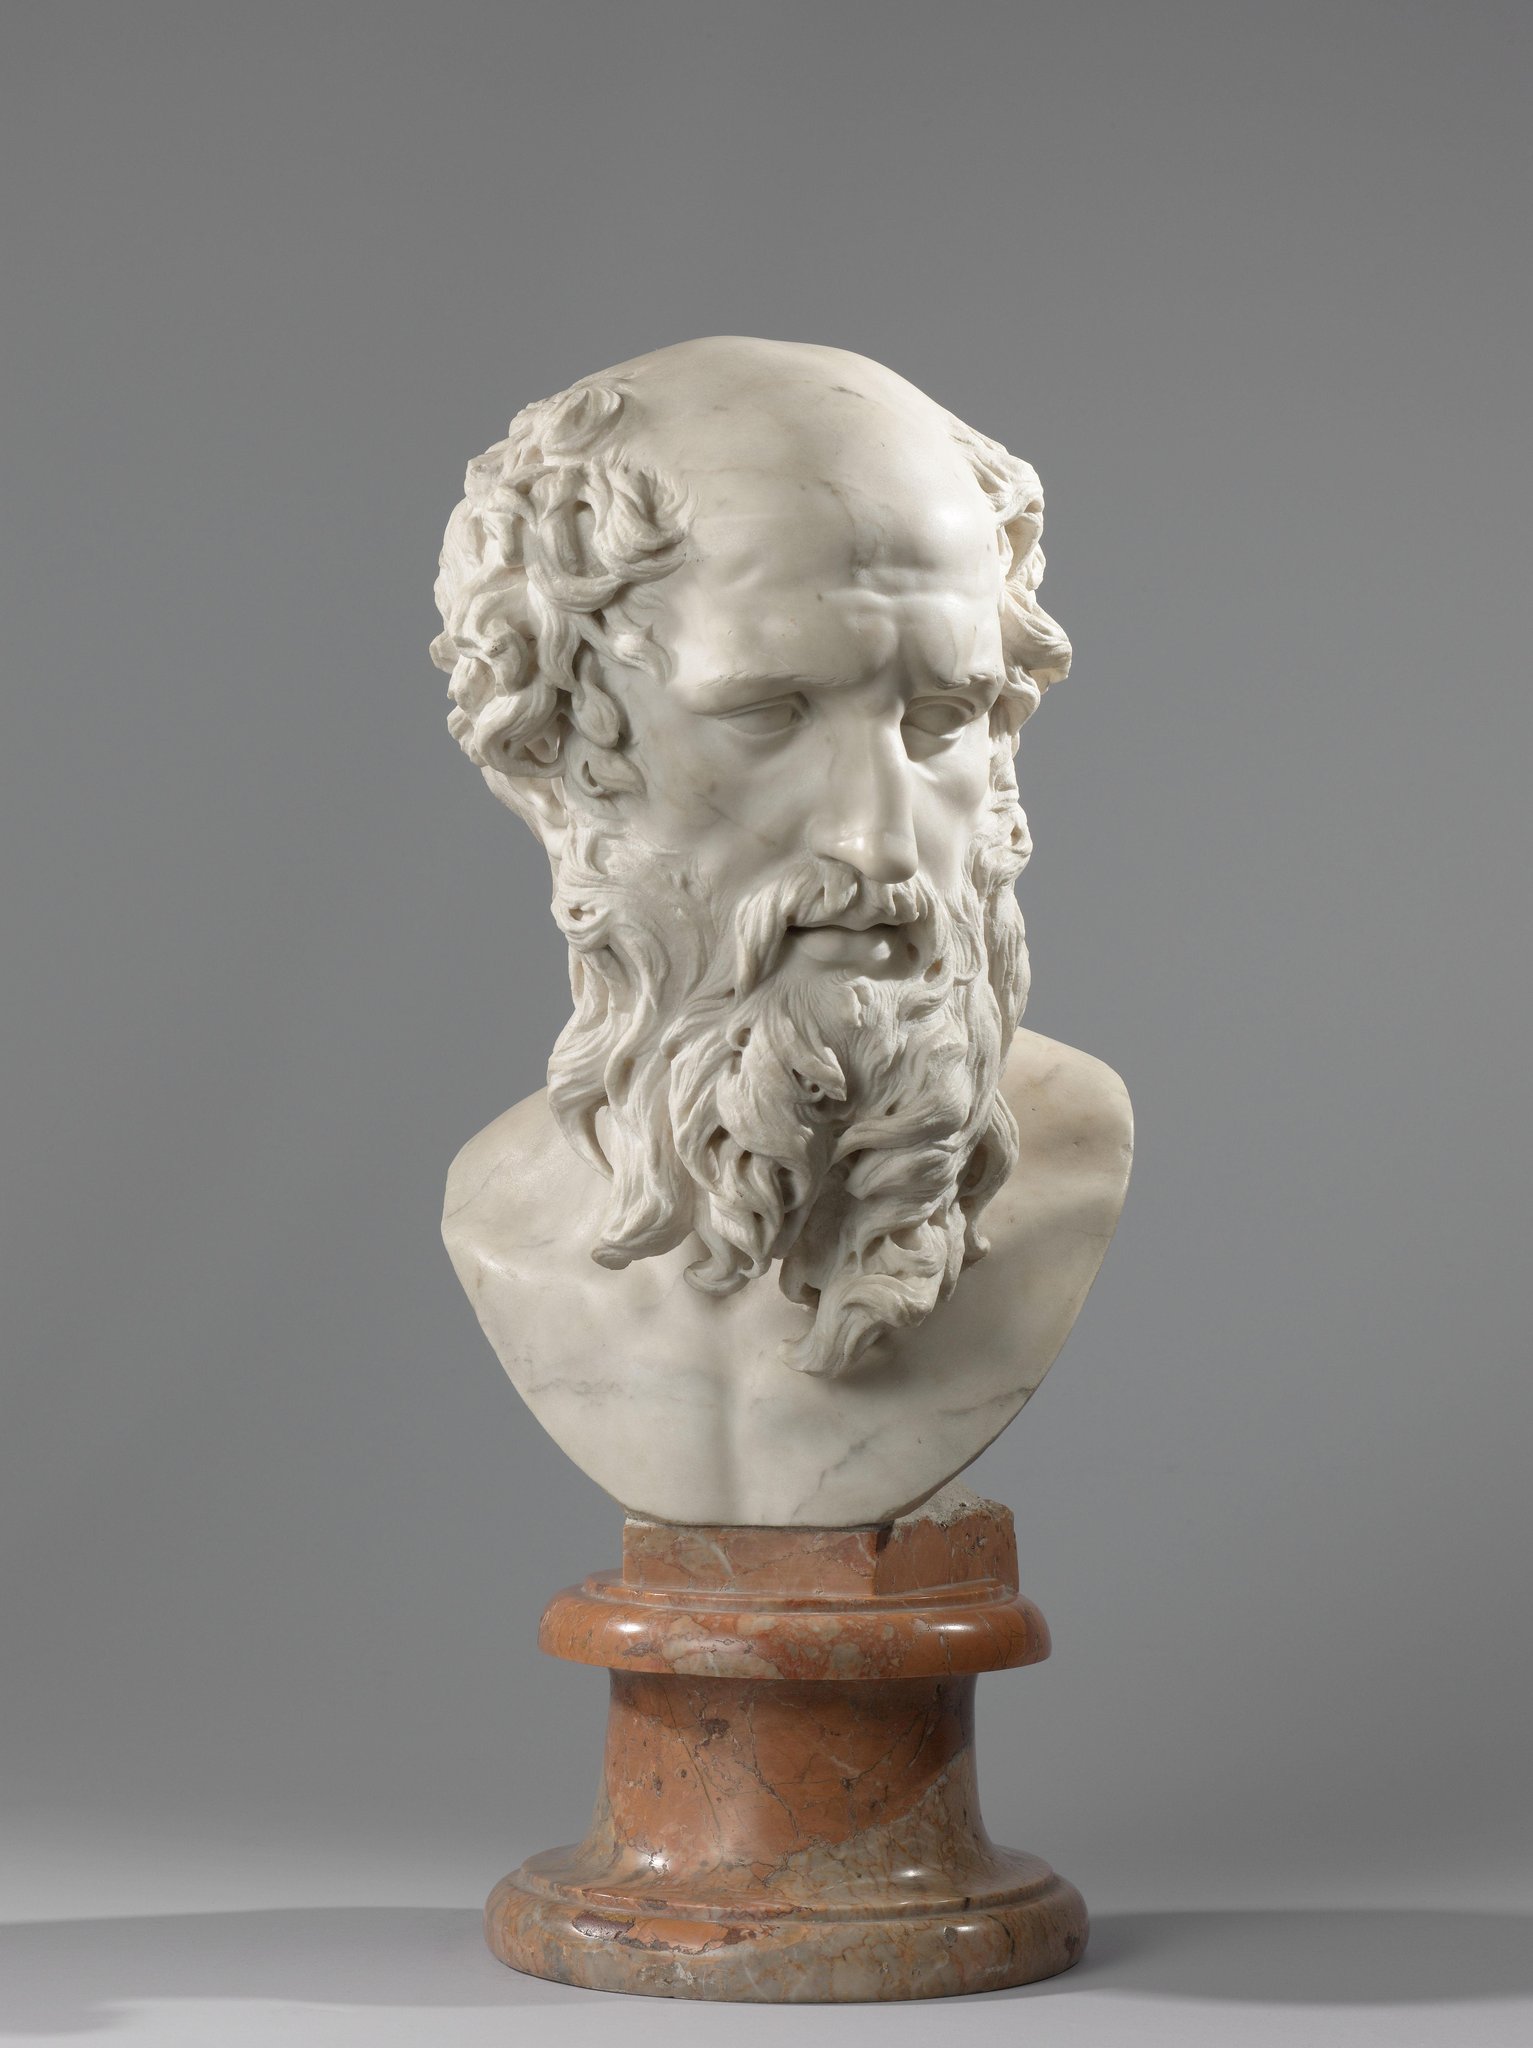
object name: sculpture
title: Plato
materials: limestone, marble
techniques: polish, carved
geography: rome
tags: athene, filosoof, plato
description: Buste van Plato, naar rechts gewend, met volle baard en kaal hoofd op vlakke vierkante sokkel van gepolijst kalksteen met mica.